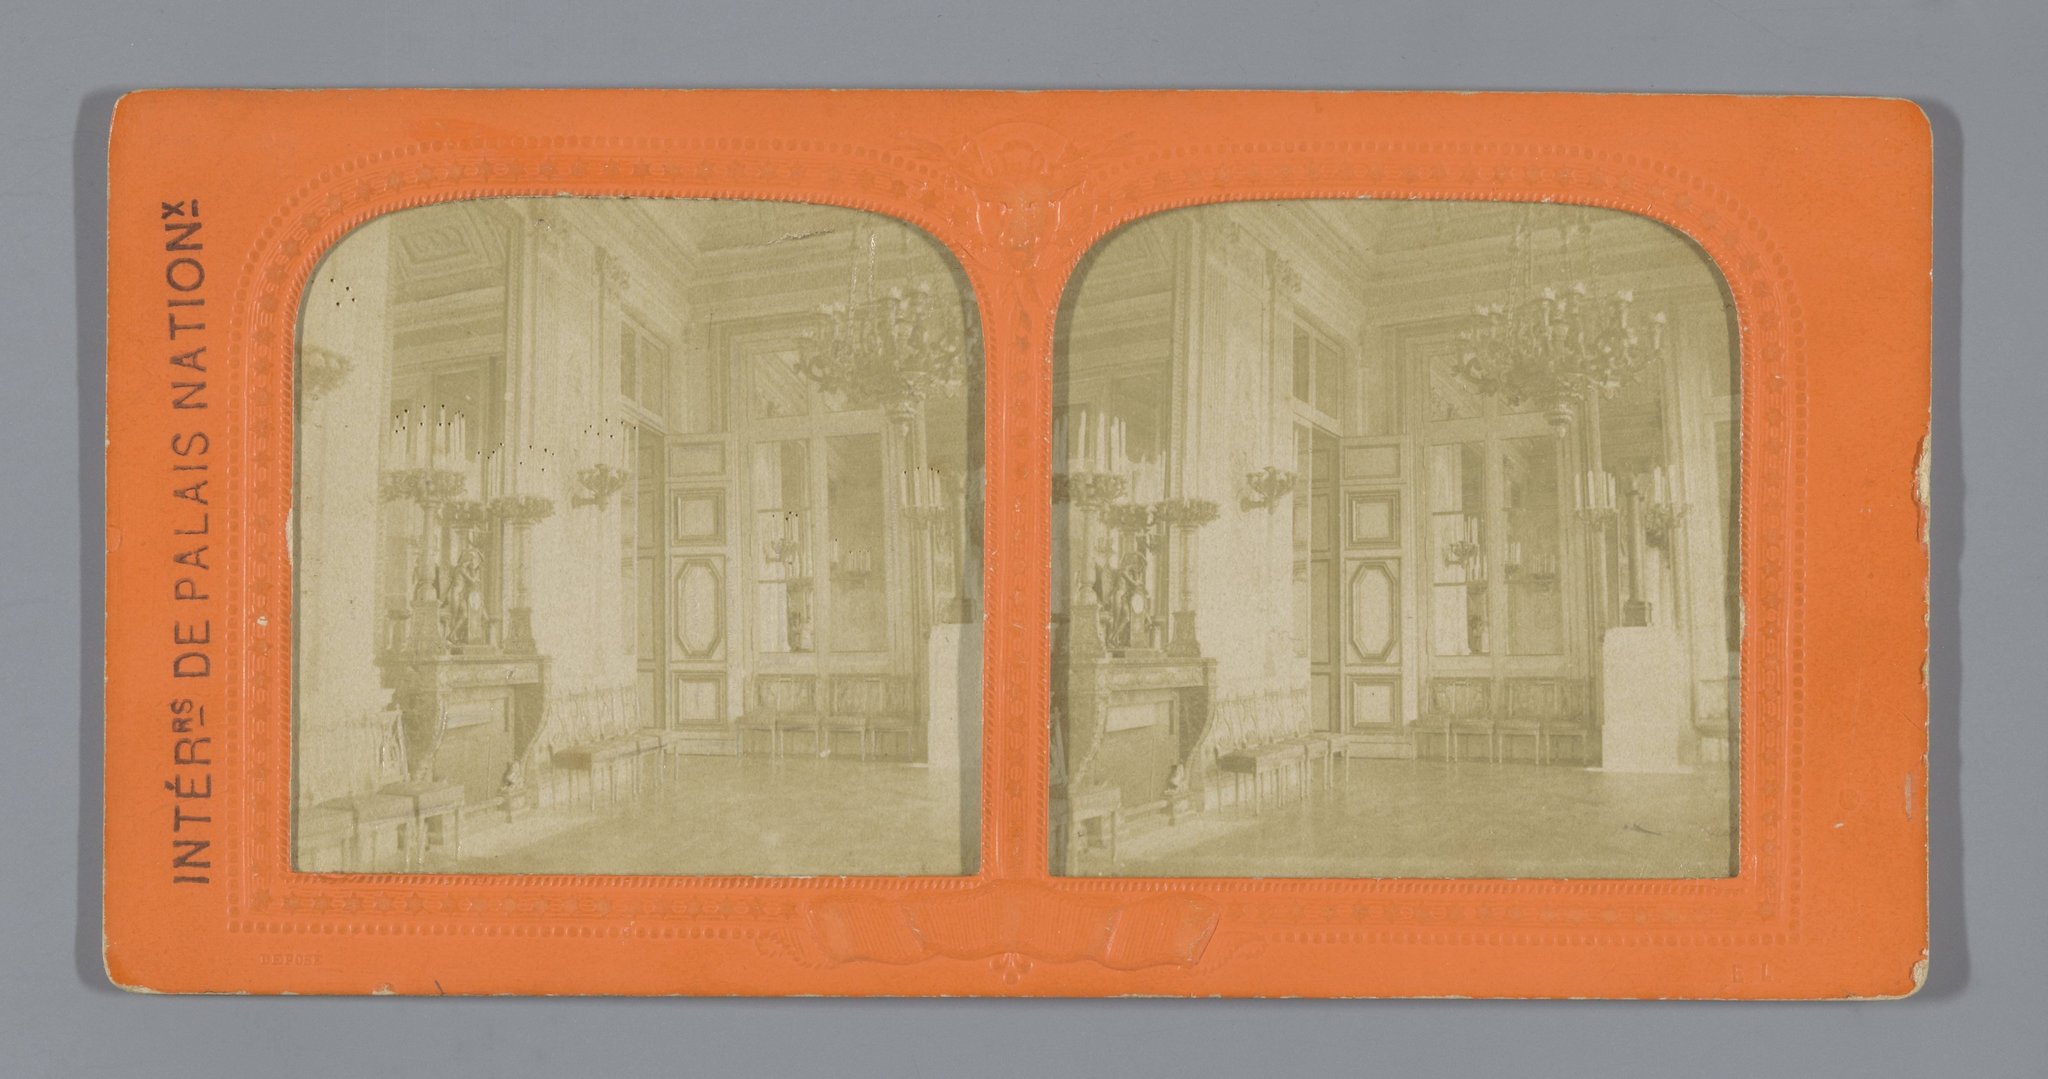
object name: tissue stereograph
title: Salle des Colonnes, hôtel de Ville, Paris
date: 1855-1875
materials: cardboard, paper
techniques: albumen print, cutting, hand coloring, perforating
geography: paris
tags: palace - aa - civic architecture: inside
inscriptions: inscription: ‘4,-’